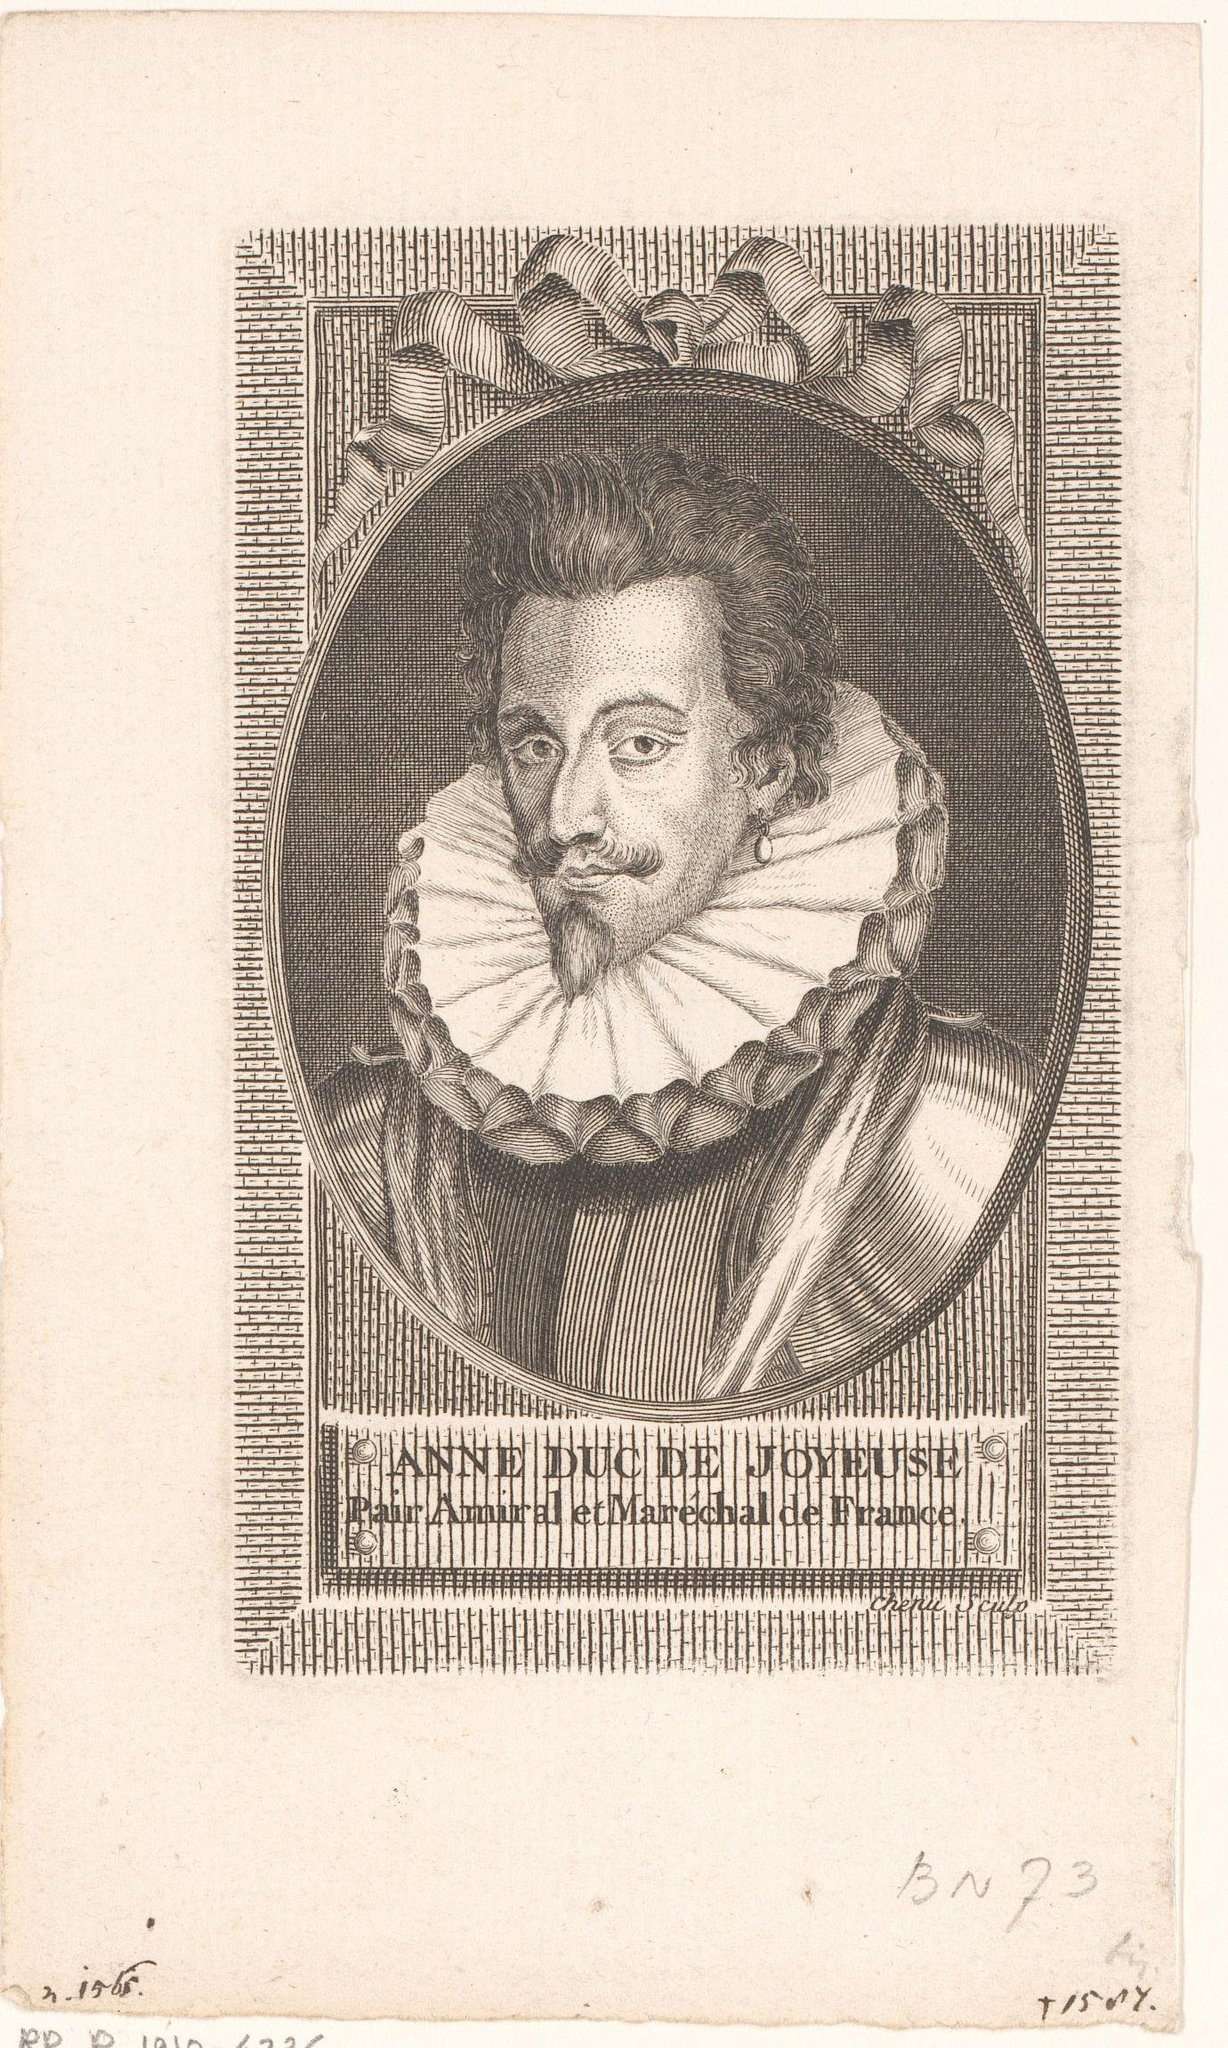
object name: book illustration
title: Portret van Anne de Batarnay de Joyeuse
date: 1766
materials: paper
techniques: engraving, etching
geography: france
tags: historical persons, ear-rings, neck-gear: collar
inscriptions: collector's mark: Lugt 2228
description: Prent uit: Bury, Richard de. Histoire de la vie de Henri IV, roi de France et de Navarre (...). Parijs: Saillant, Charles, 1766.